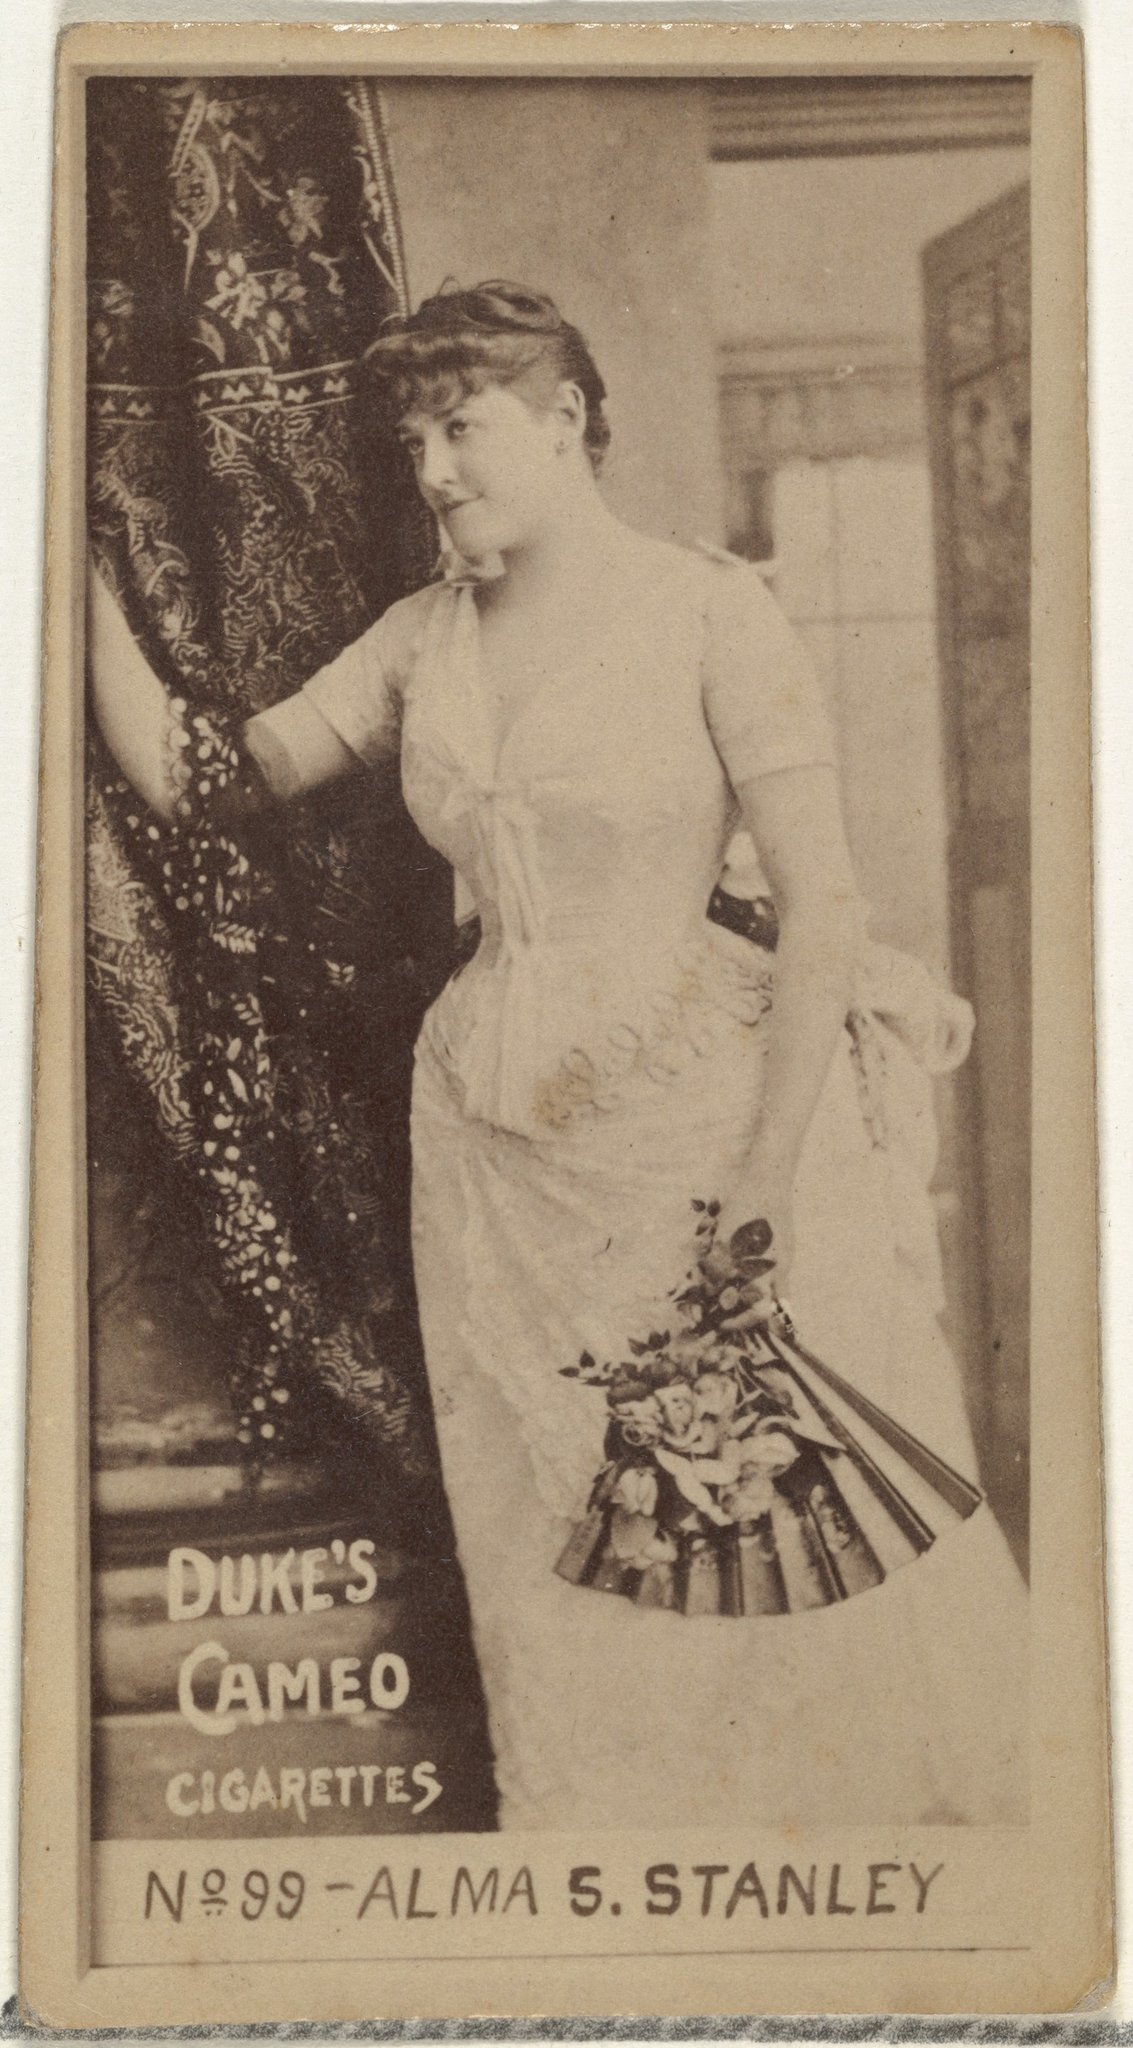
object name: photograph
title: Card Number 99, Alma S. Stanley, from the Actors and Actresses series (N145-4) issued by Duke Sons & Co. to promote Cameo Cigarettes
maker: w. duke, sons & co.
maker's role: publisher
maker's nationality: american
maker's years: 1870-1920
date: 1880-1889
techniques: albumen silver print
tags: portraits,women,actresses